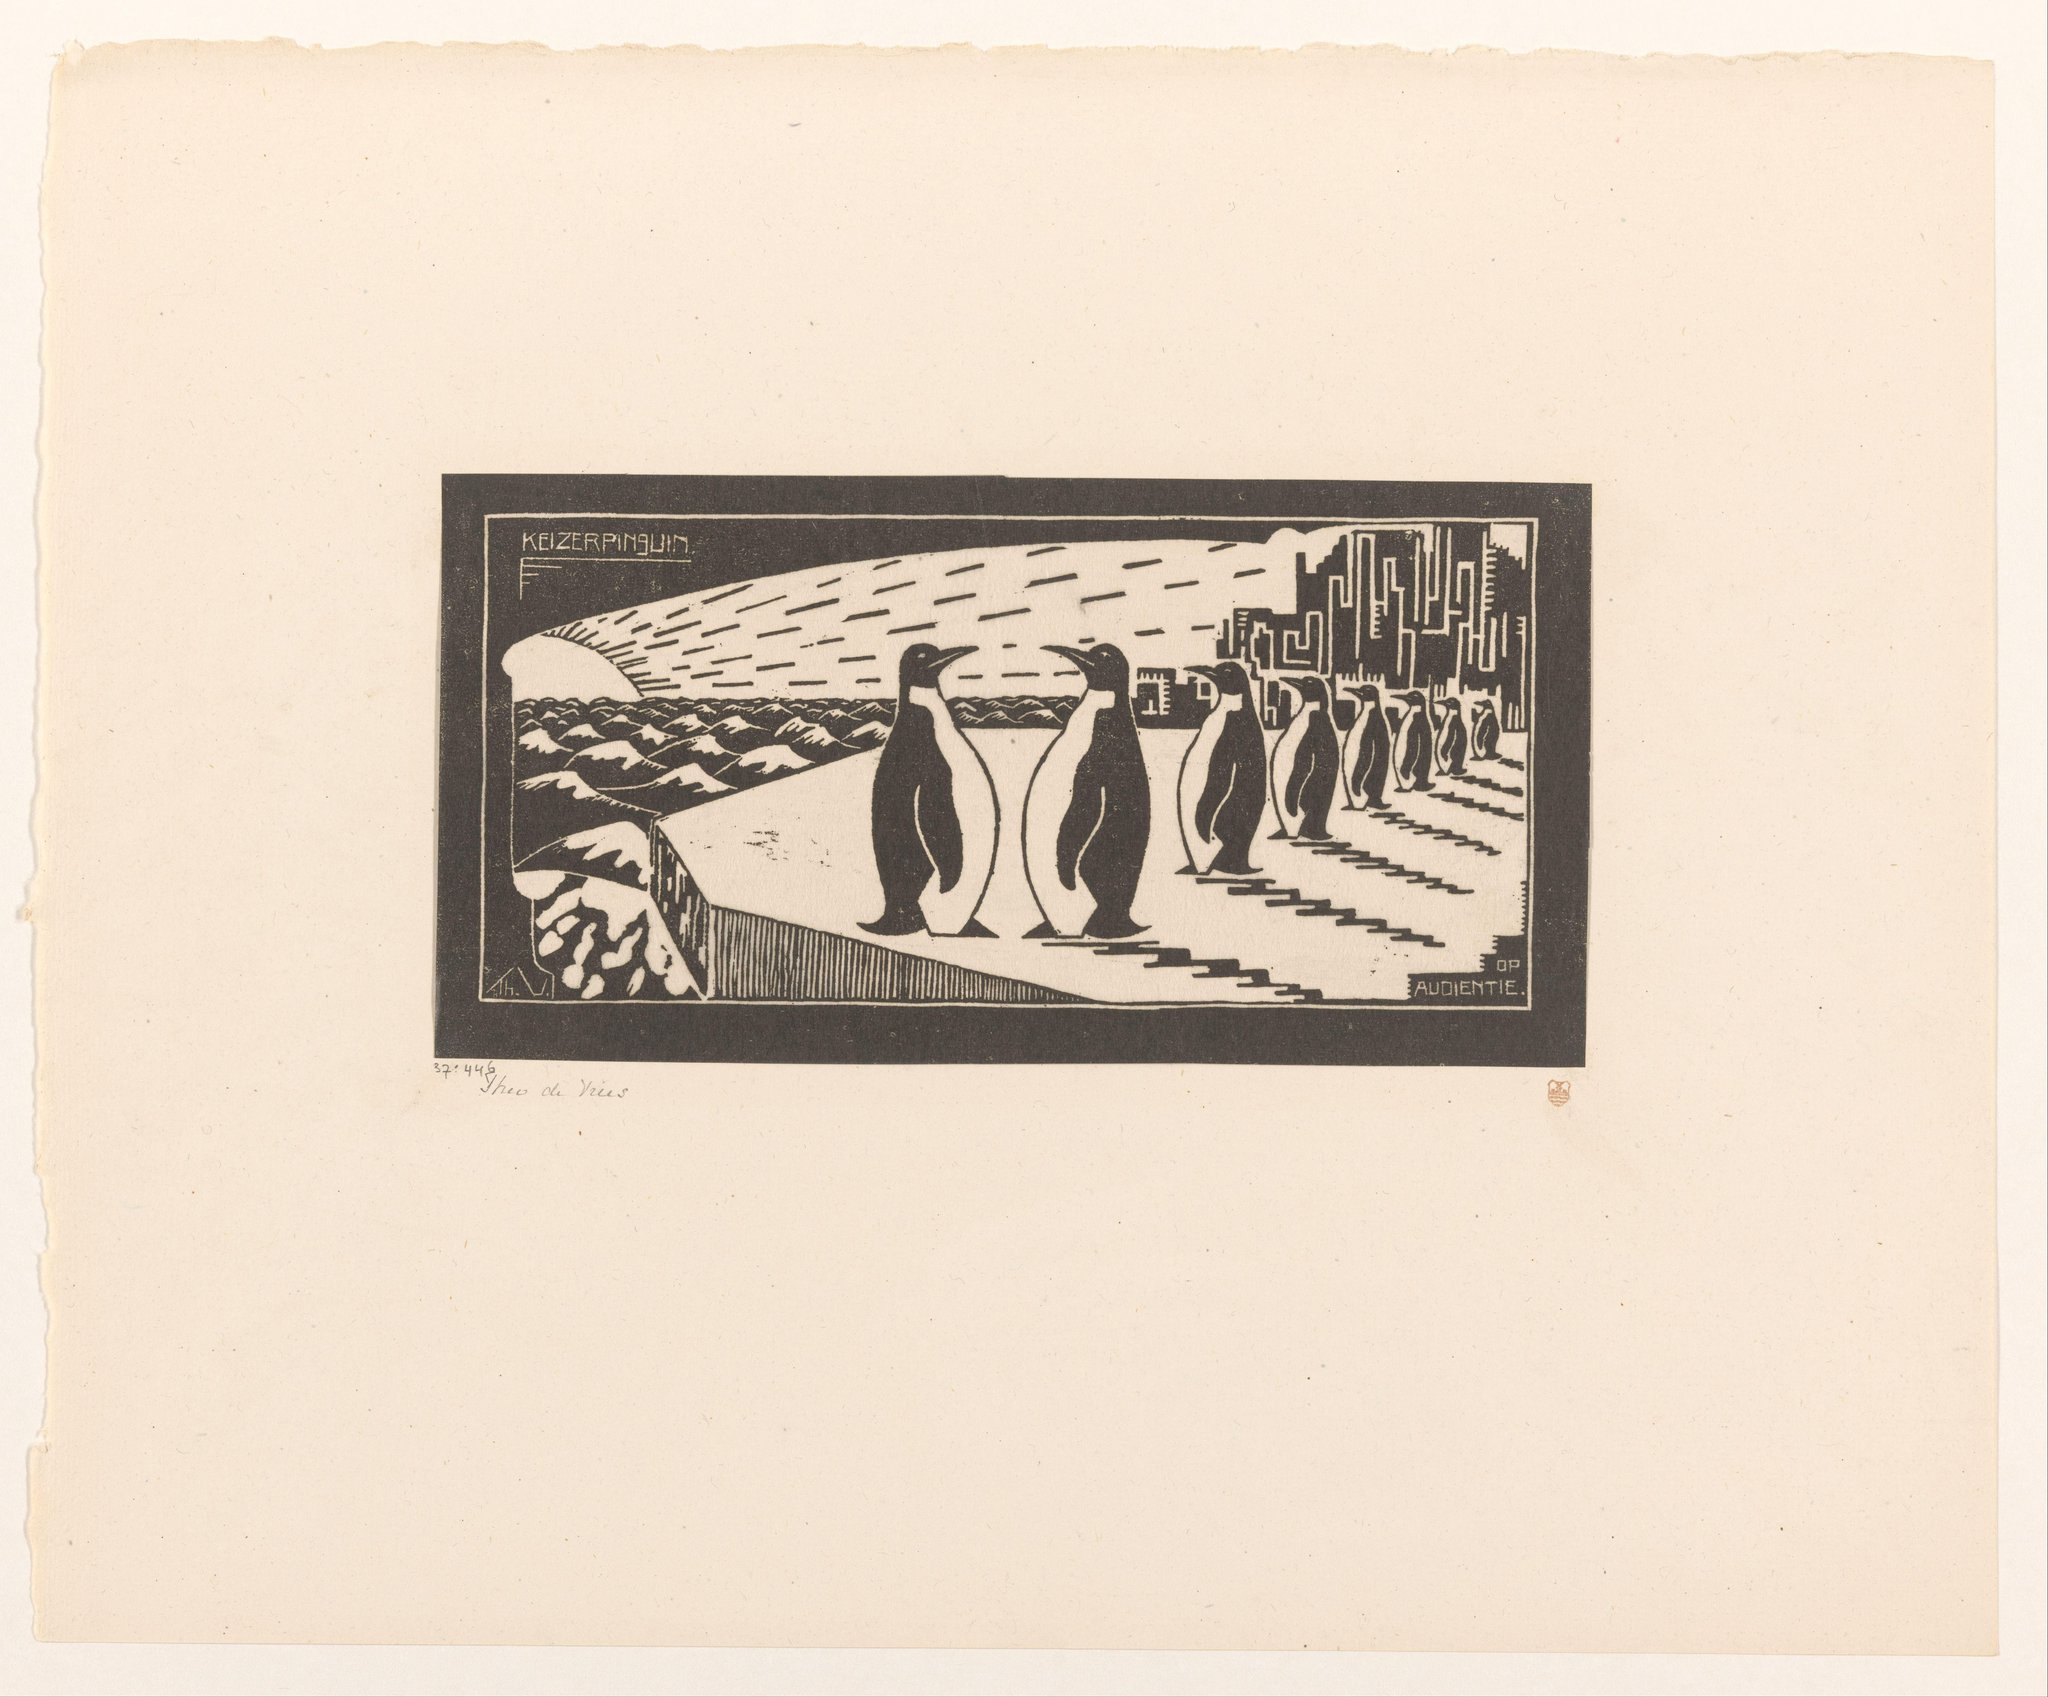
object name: print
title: Keizerpinguin op audientie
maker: theo de vries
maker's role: print maker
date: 1927-1937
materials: paper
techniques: woodcut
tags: water-birds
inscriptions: collector's mark: Lugt 2228, collector's mark: Lugt 2760